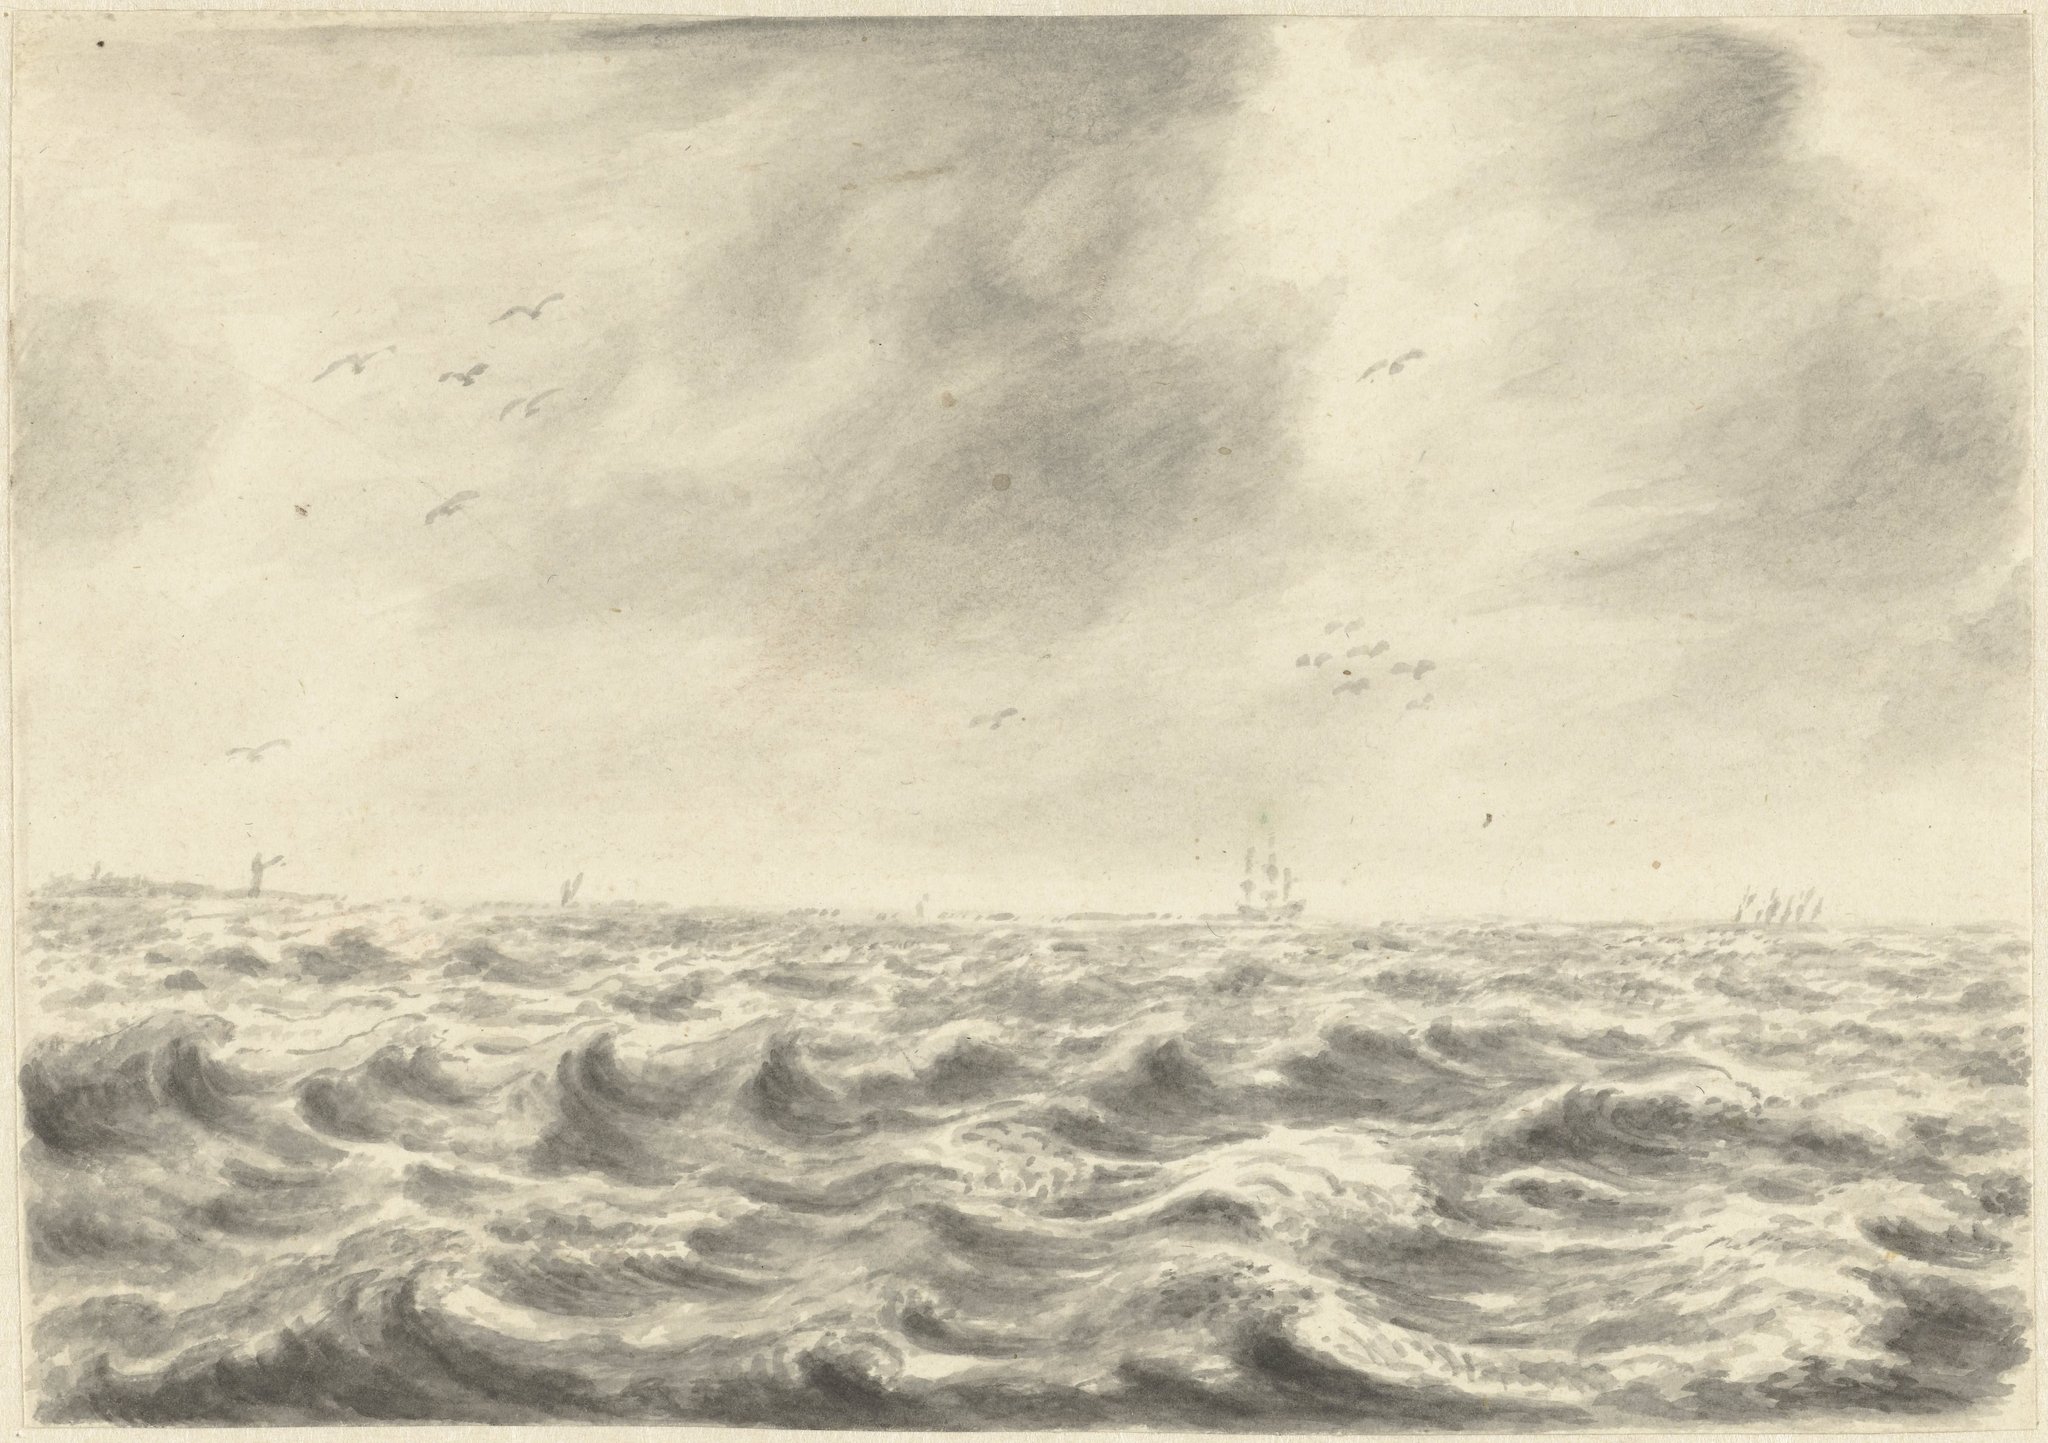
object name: drawing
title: Zeegezicht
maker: pieter idserts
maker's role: draughtsman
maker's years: 1698-1781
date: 1708-1781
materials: paper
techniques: brush